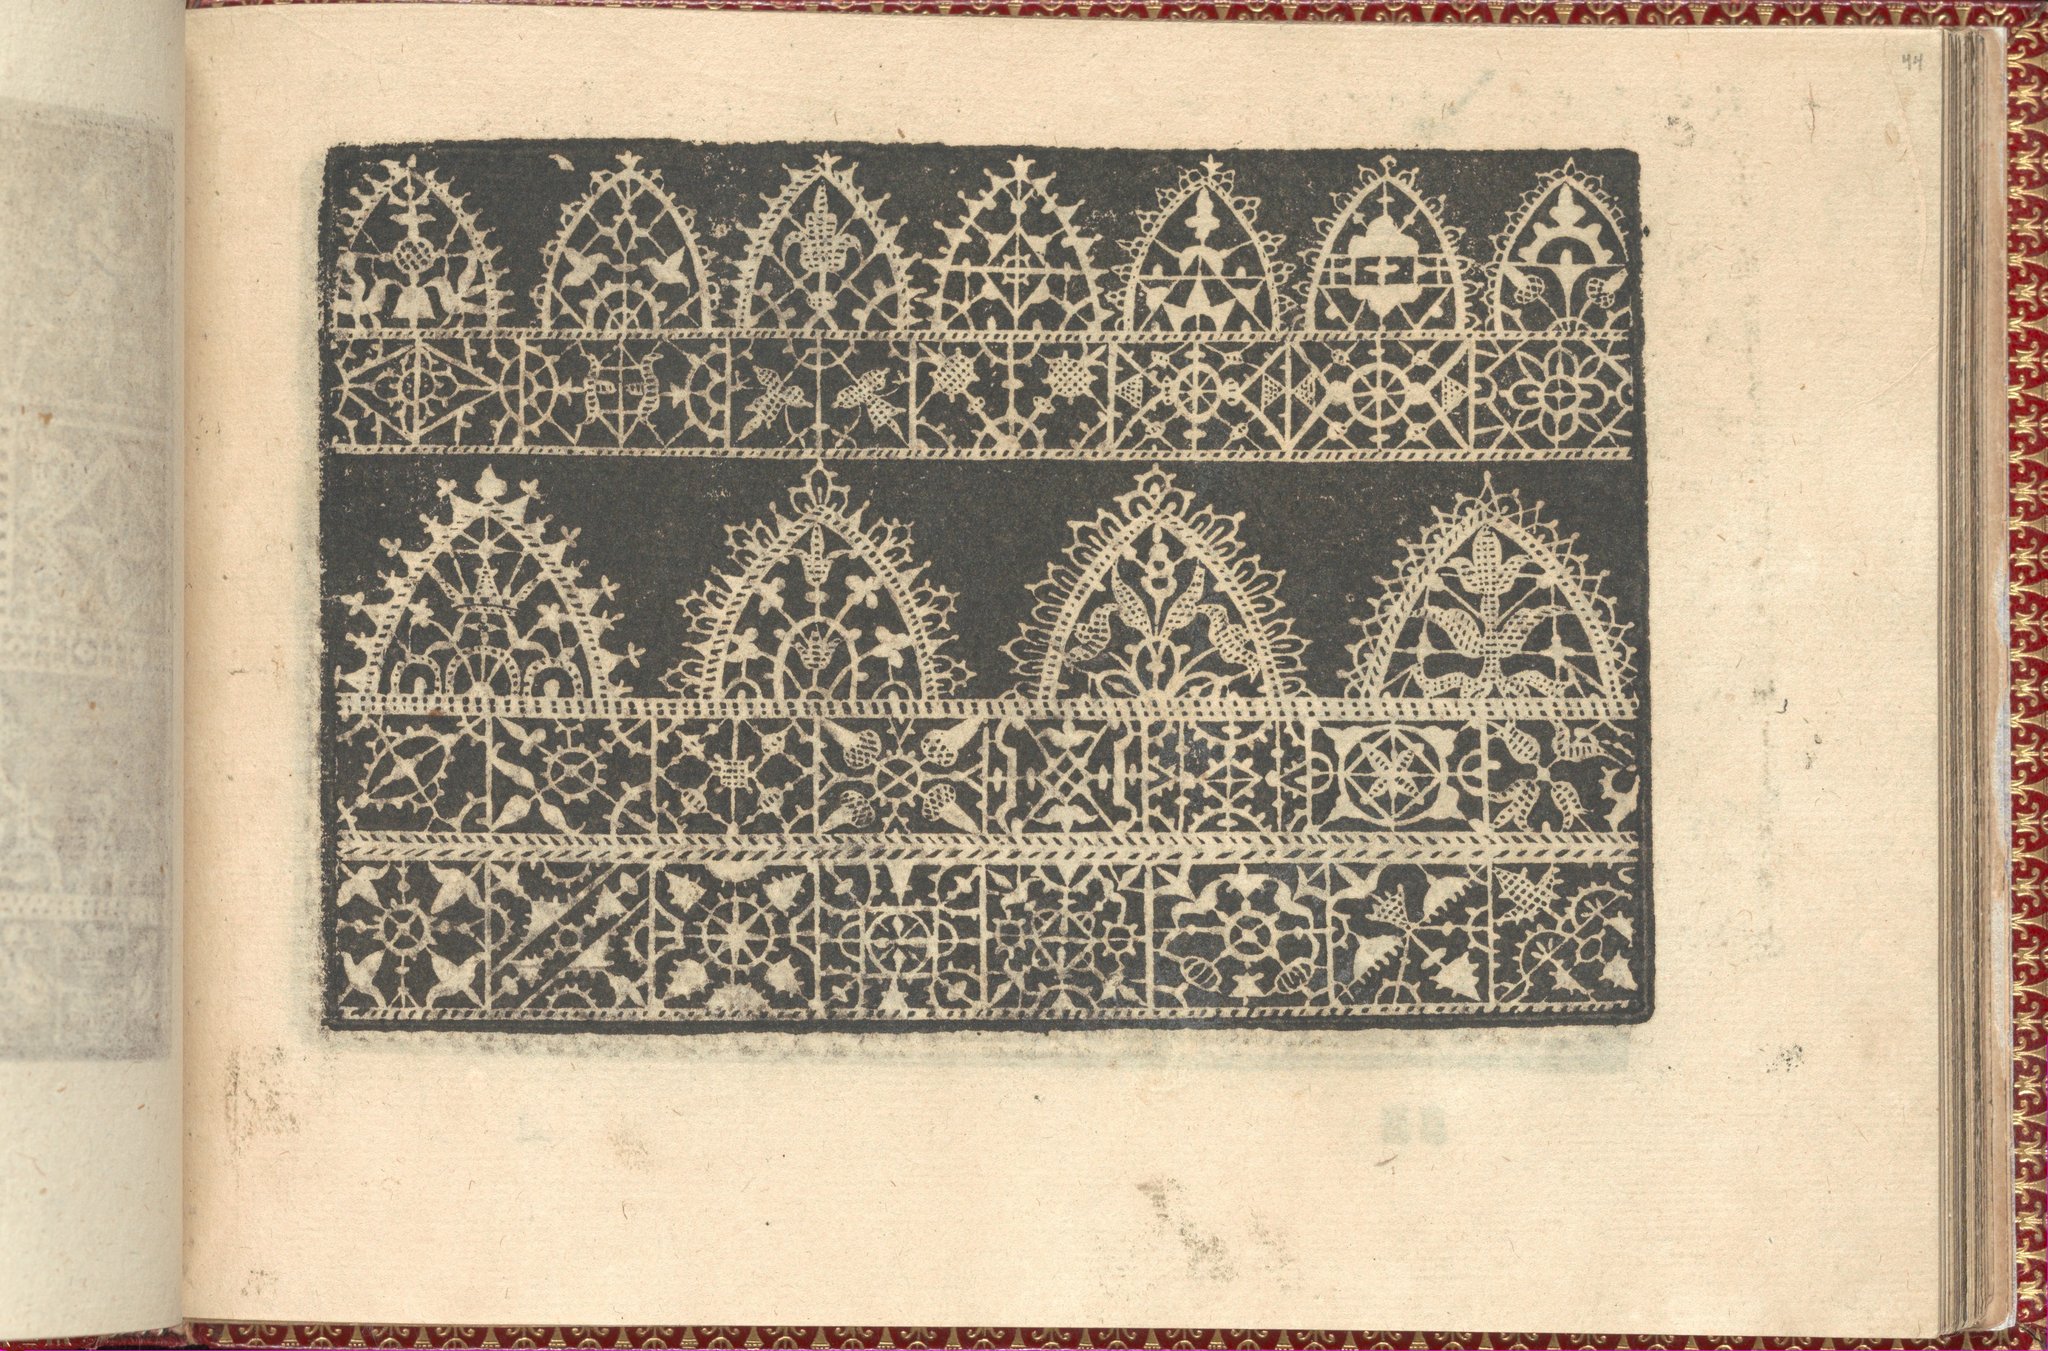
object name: book print ornament architecture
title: Corona delle Nobili et Virtuose Donne: Libro I-IV, page 44 (recto)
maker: cesare vecellio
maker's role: publisher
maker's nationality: italian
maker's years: 1521-1601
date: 1601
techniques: woodcut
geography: italy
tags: ornament